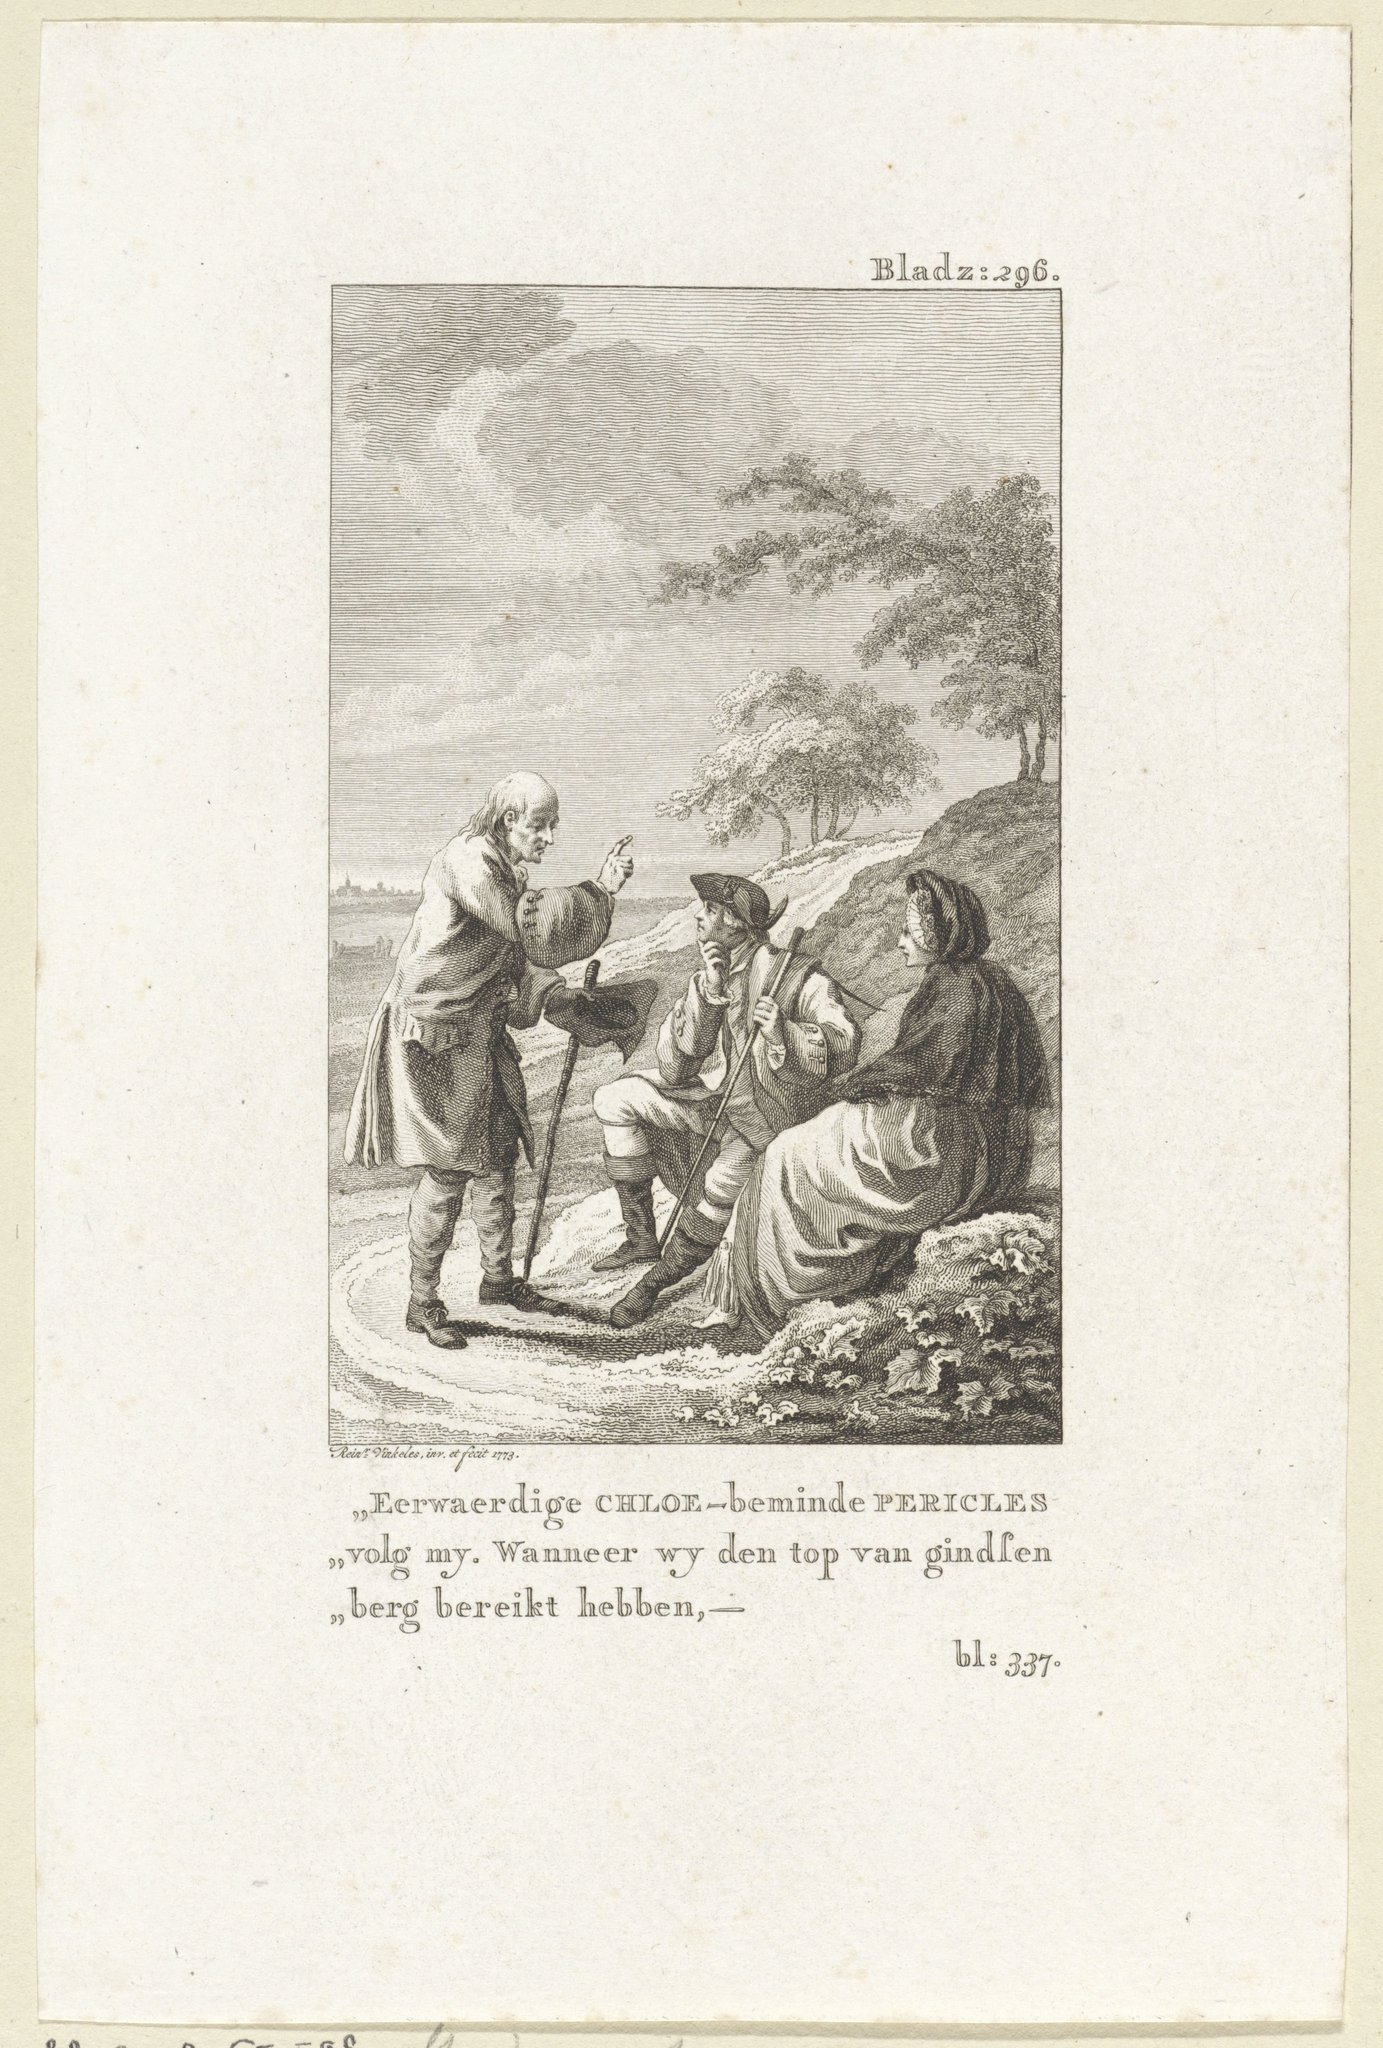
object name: print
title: Oude man vraagt Chloe en Pericles hem te volgen naar de bergen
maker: reinier vinkeles (i)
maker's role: draughtsman, print maker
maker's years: 1741-1816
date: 1773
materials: paper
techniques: engraving, etching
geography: amsterdam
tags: low hill country, (traveller) resting in the open air, 'en route', traveller under way, index finger forwards, pointing, indicating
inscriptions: collector's mark: Lugt 240, inscription: ‘"Eerwaerdige Chloe - beminde pericles / "volg my. Wanneer wy den top van gindsen / "berg bereikt hebben, - / bl: 337’